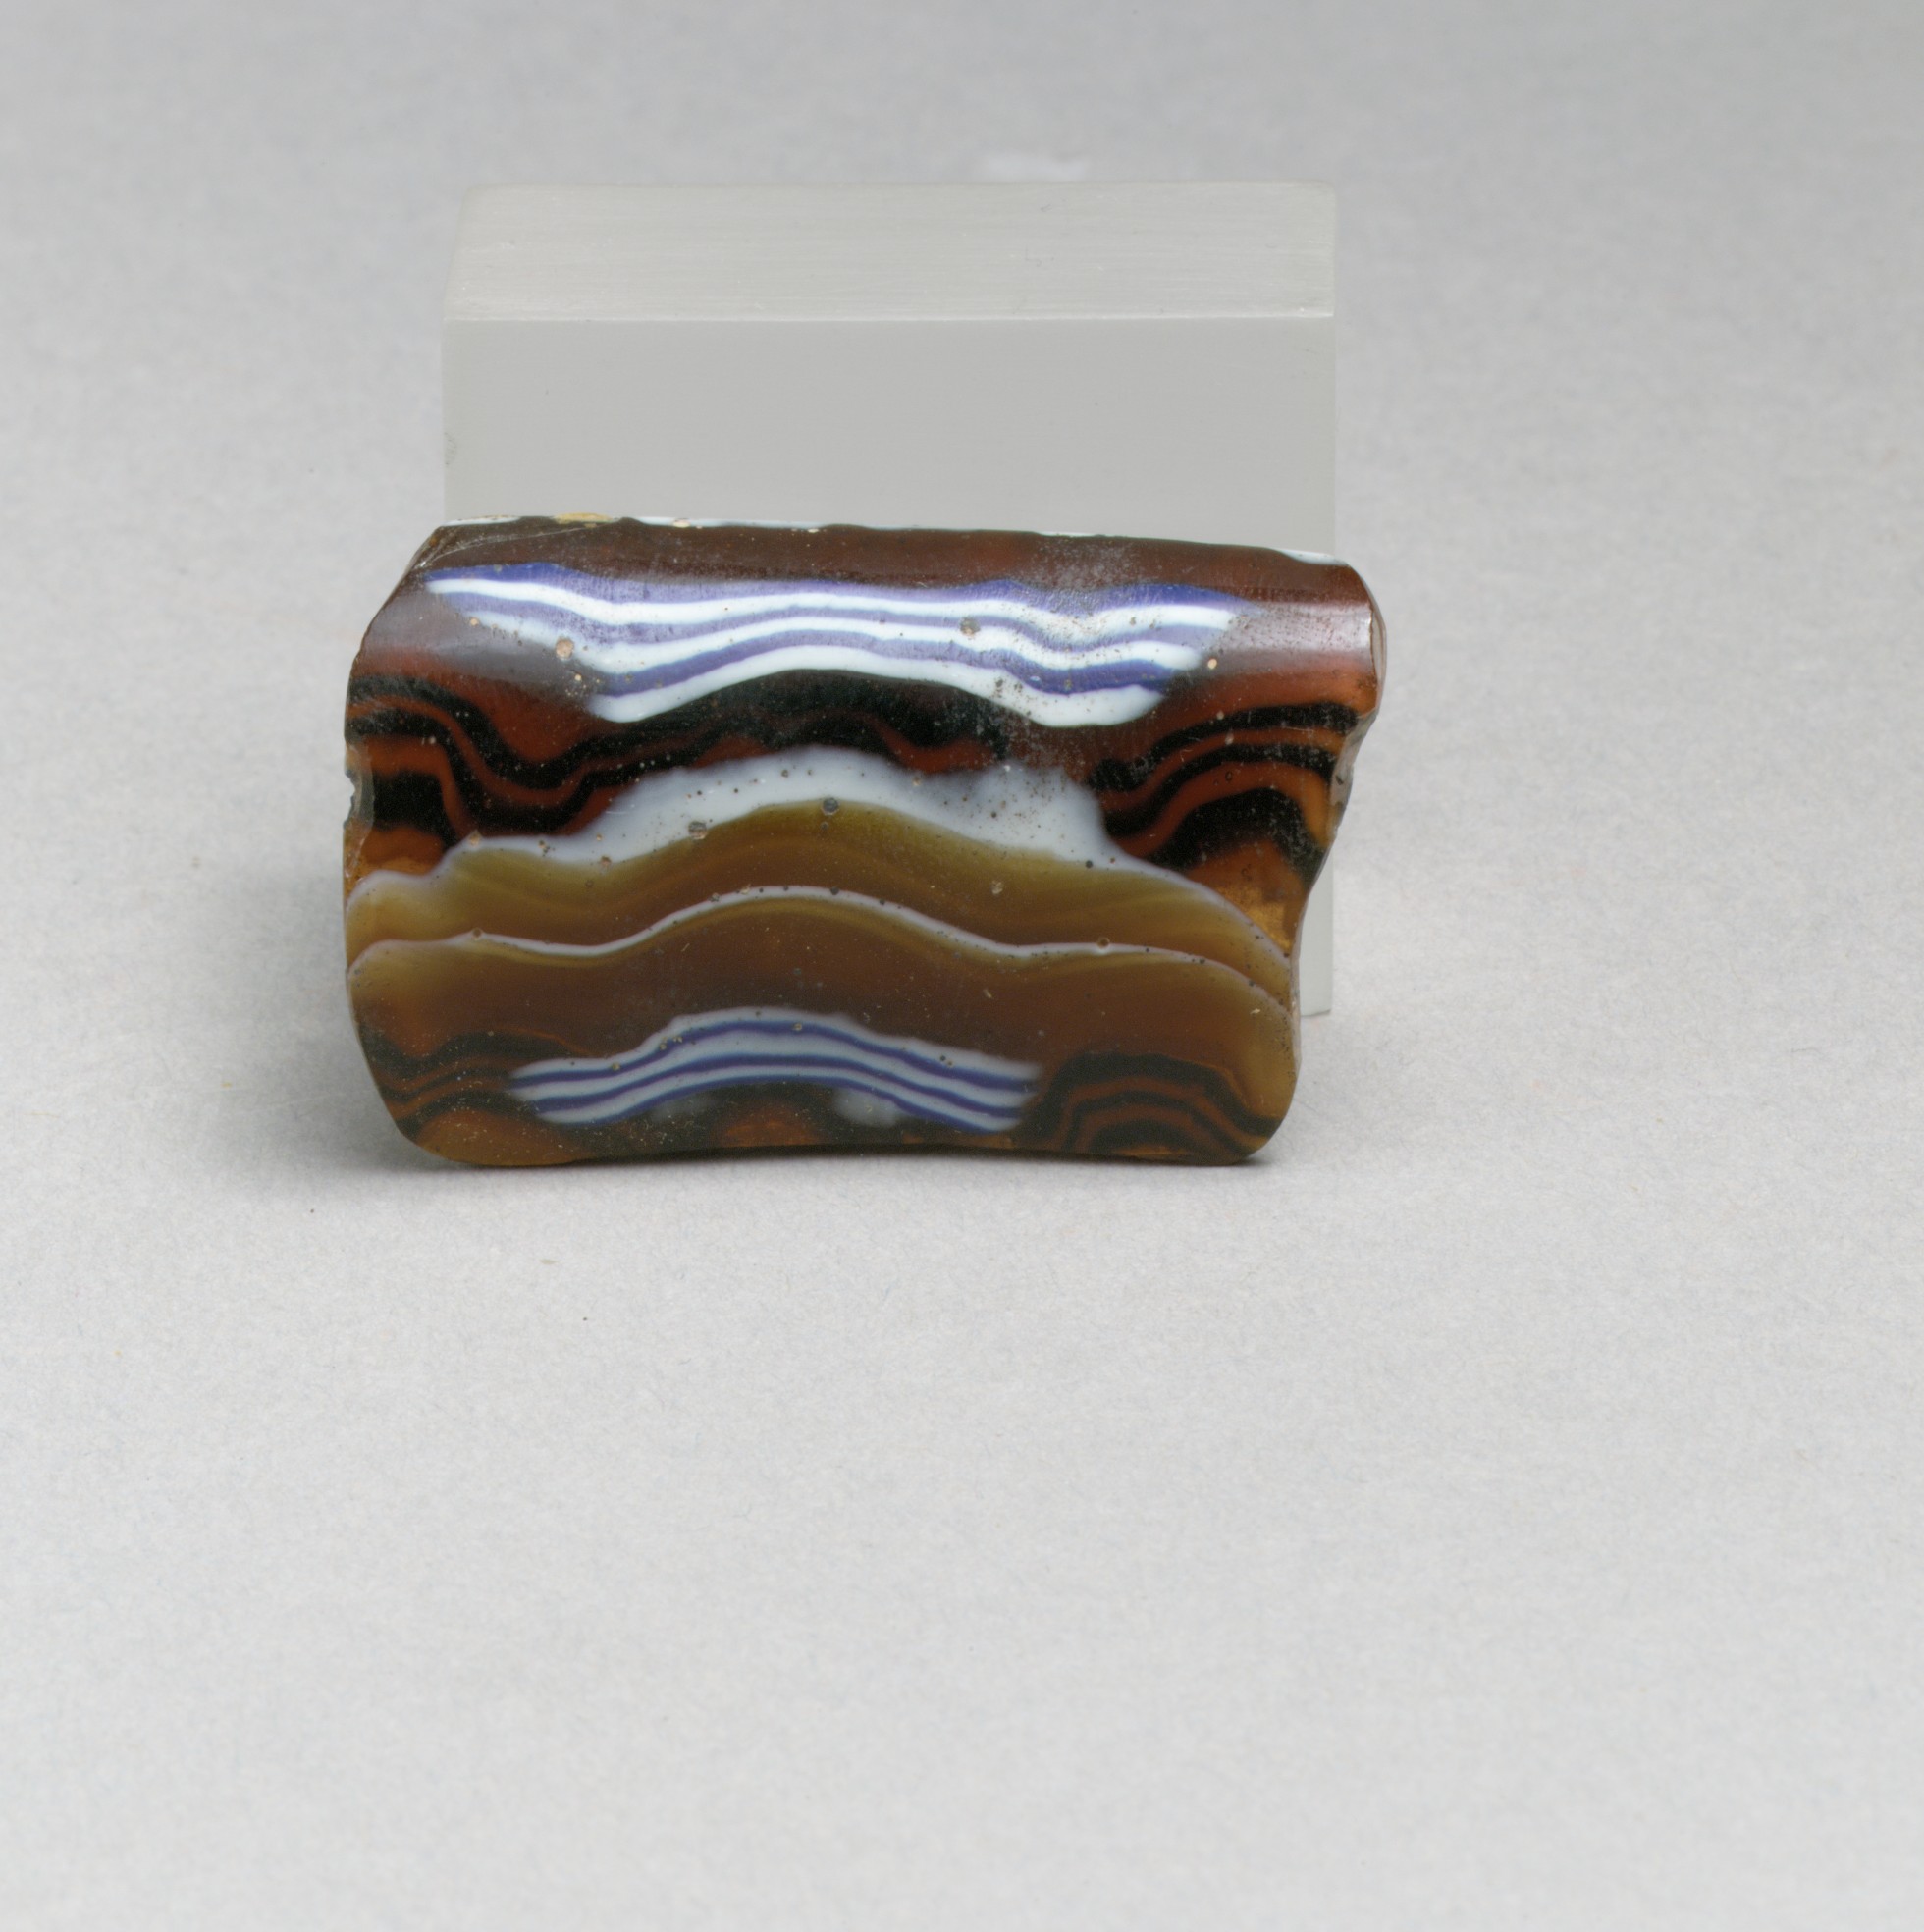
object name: fragment, mosaic bowl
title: Glass mosaic ribbed bowl fragment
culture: roman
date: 34 BCE-33 CE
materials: glass